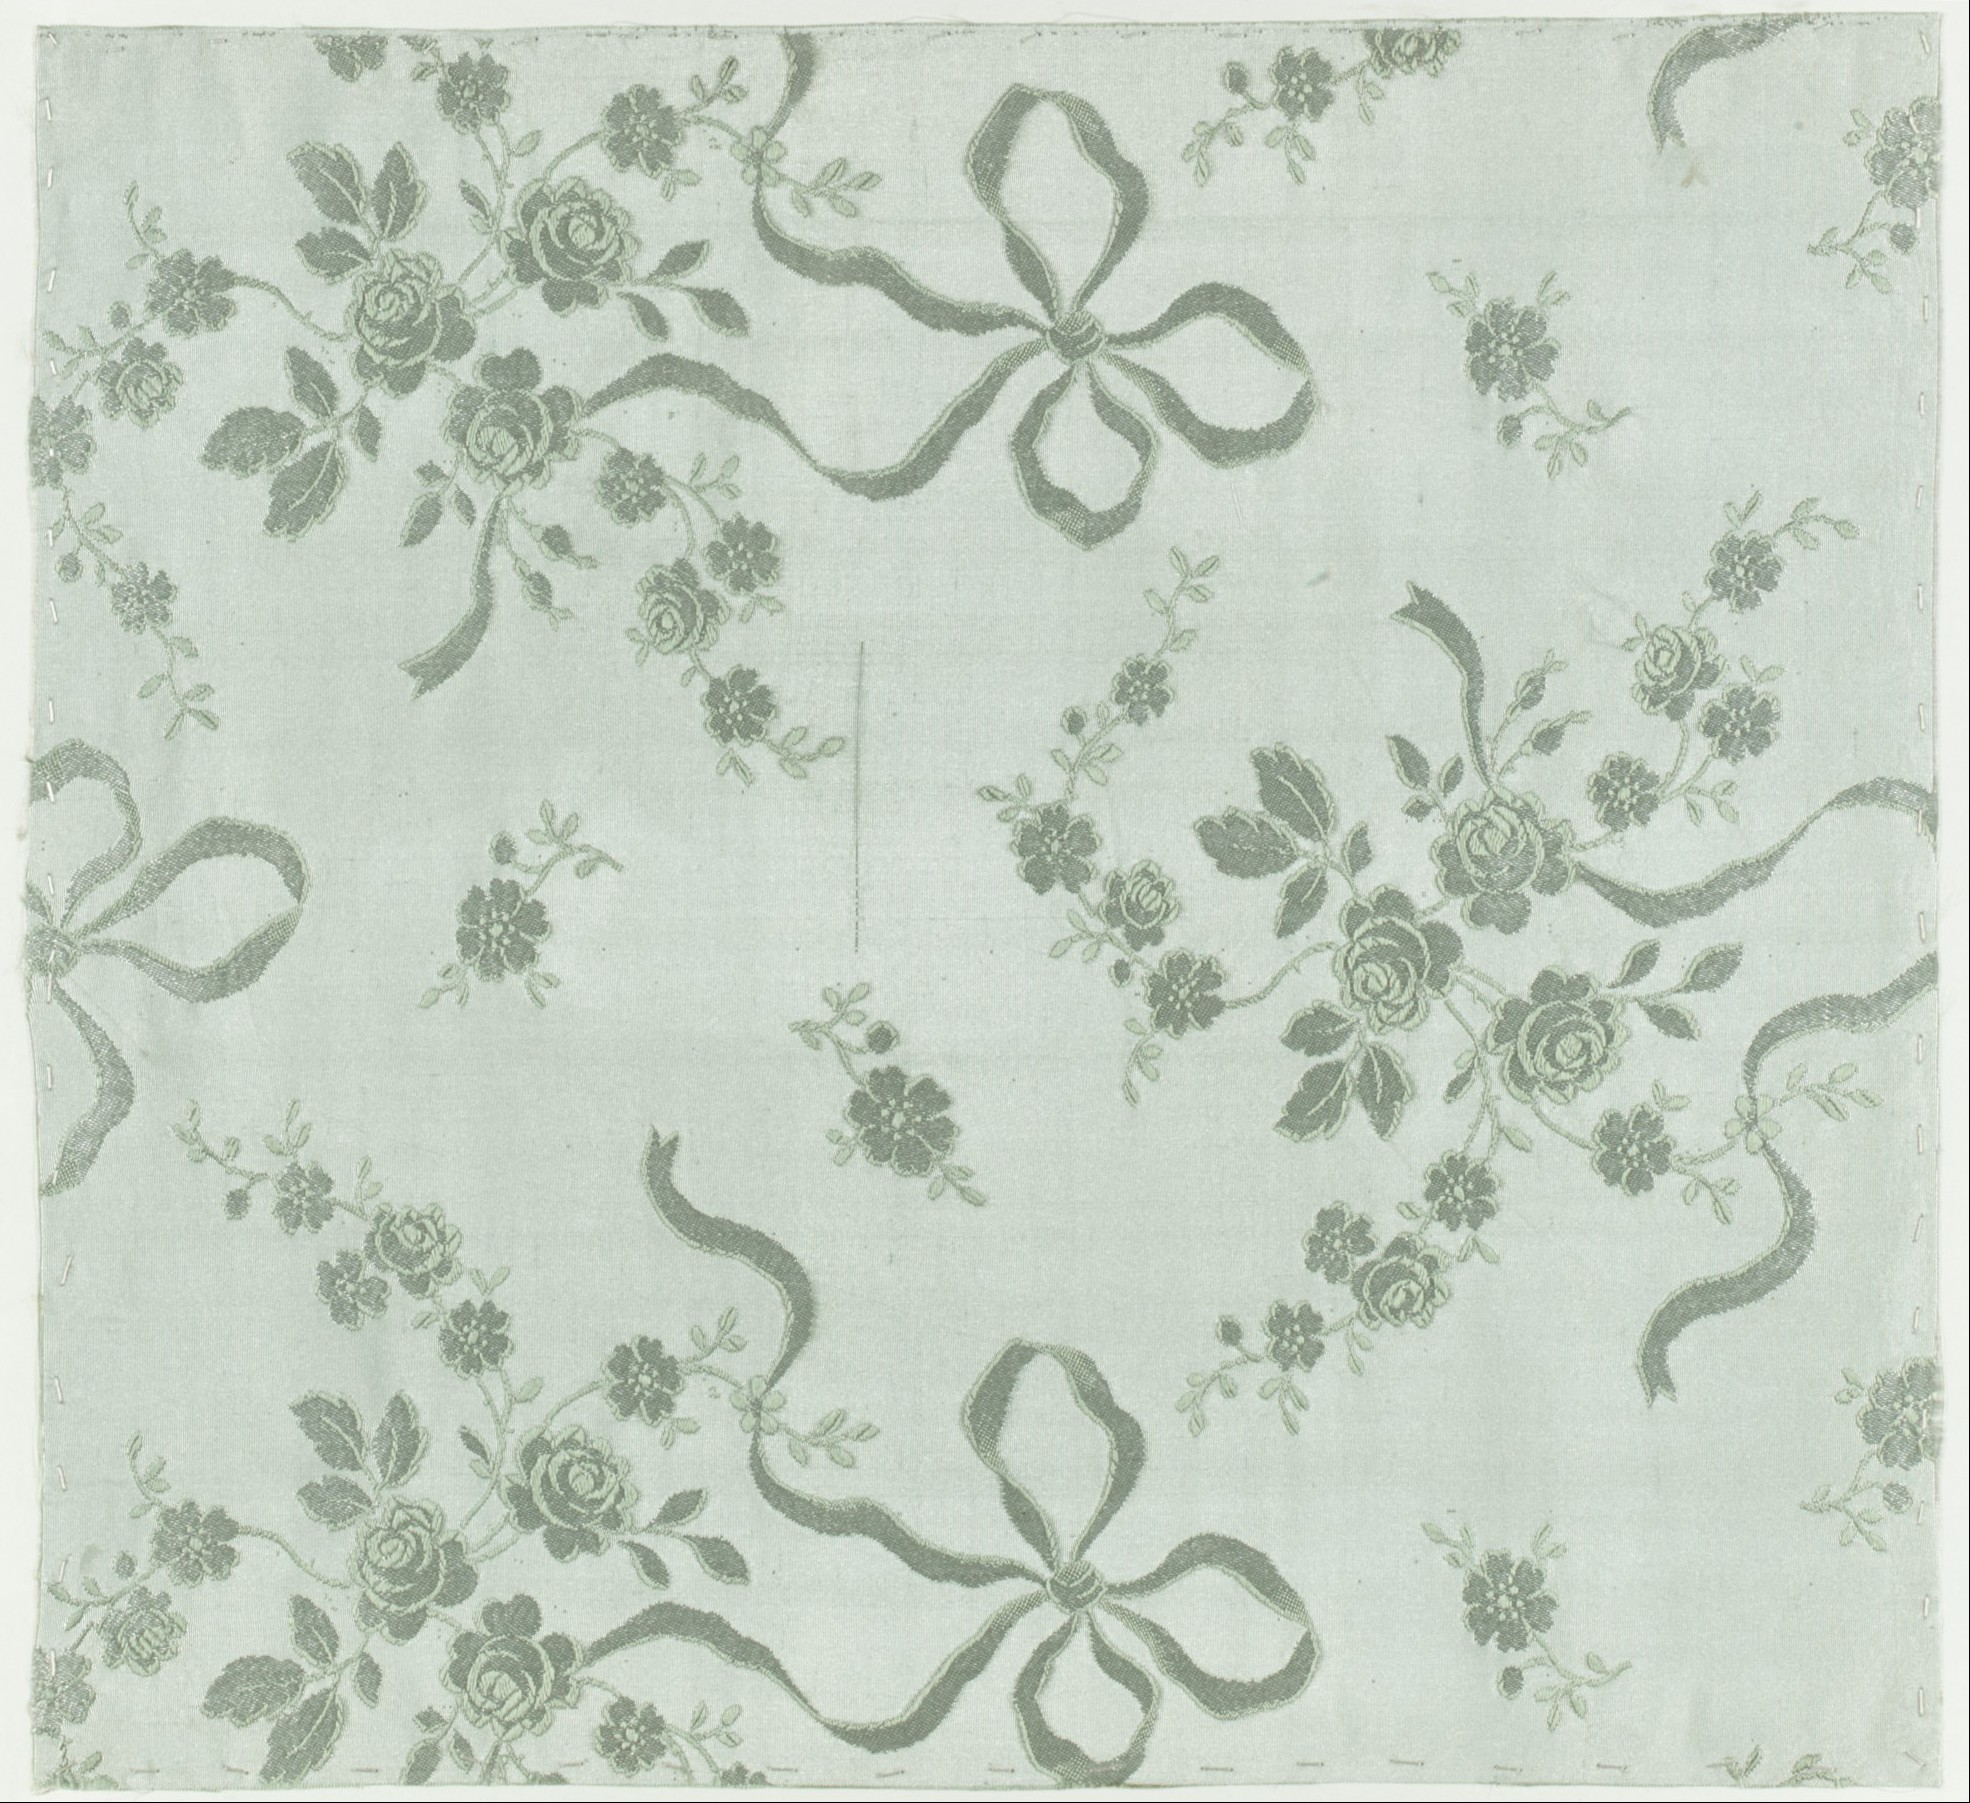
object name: textile sample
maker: Anonymous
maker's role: designer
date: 1900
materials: silk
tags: flowers